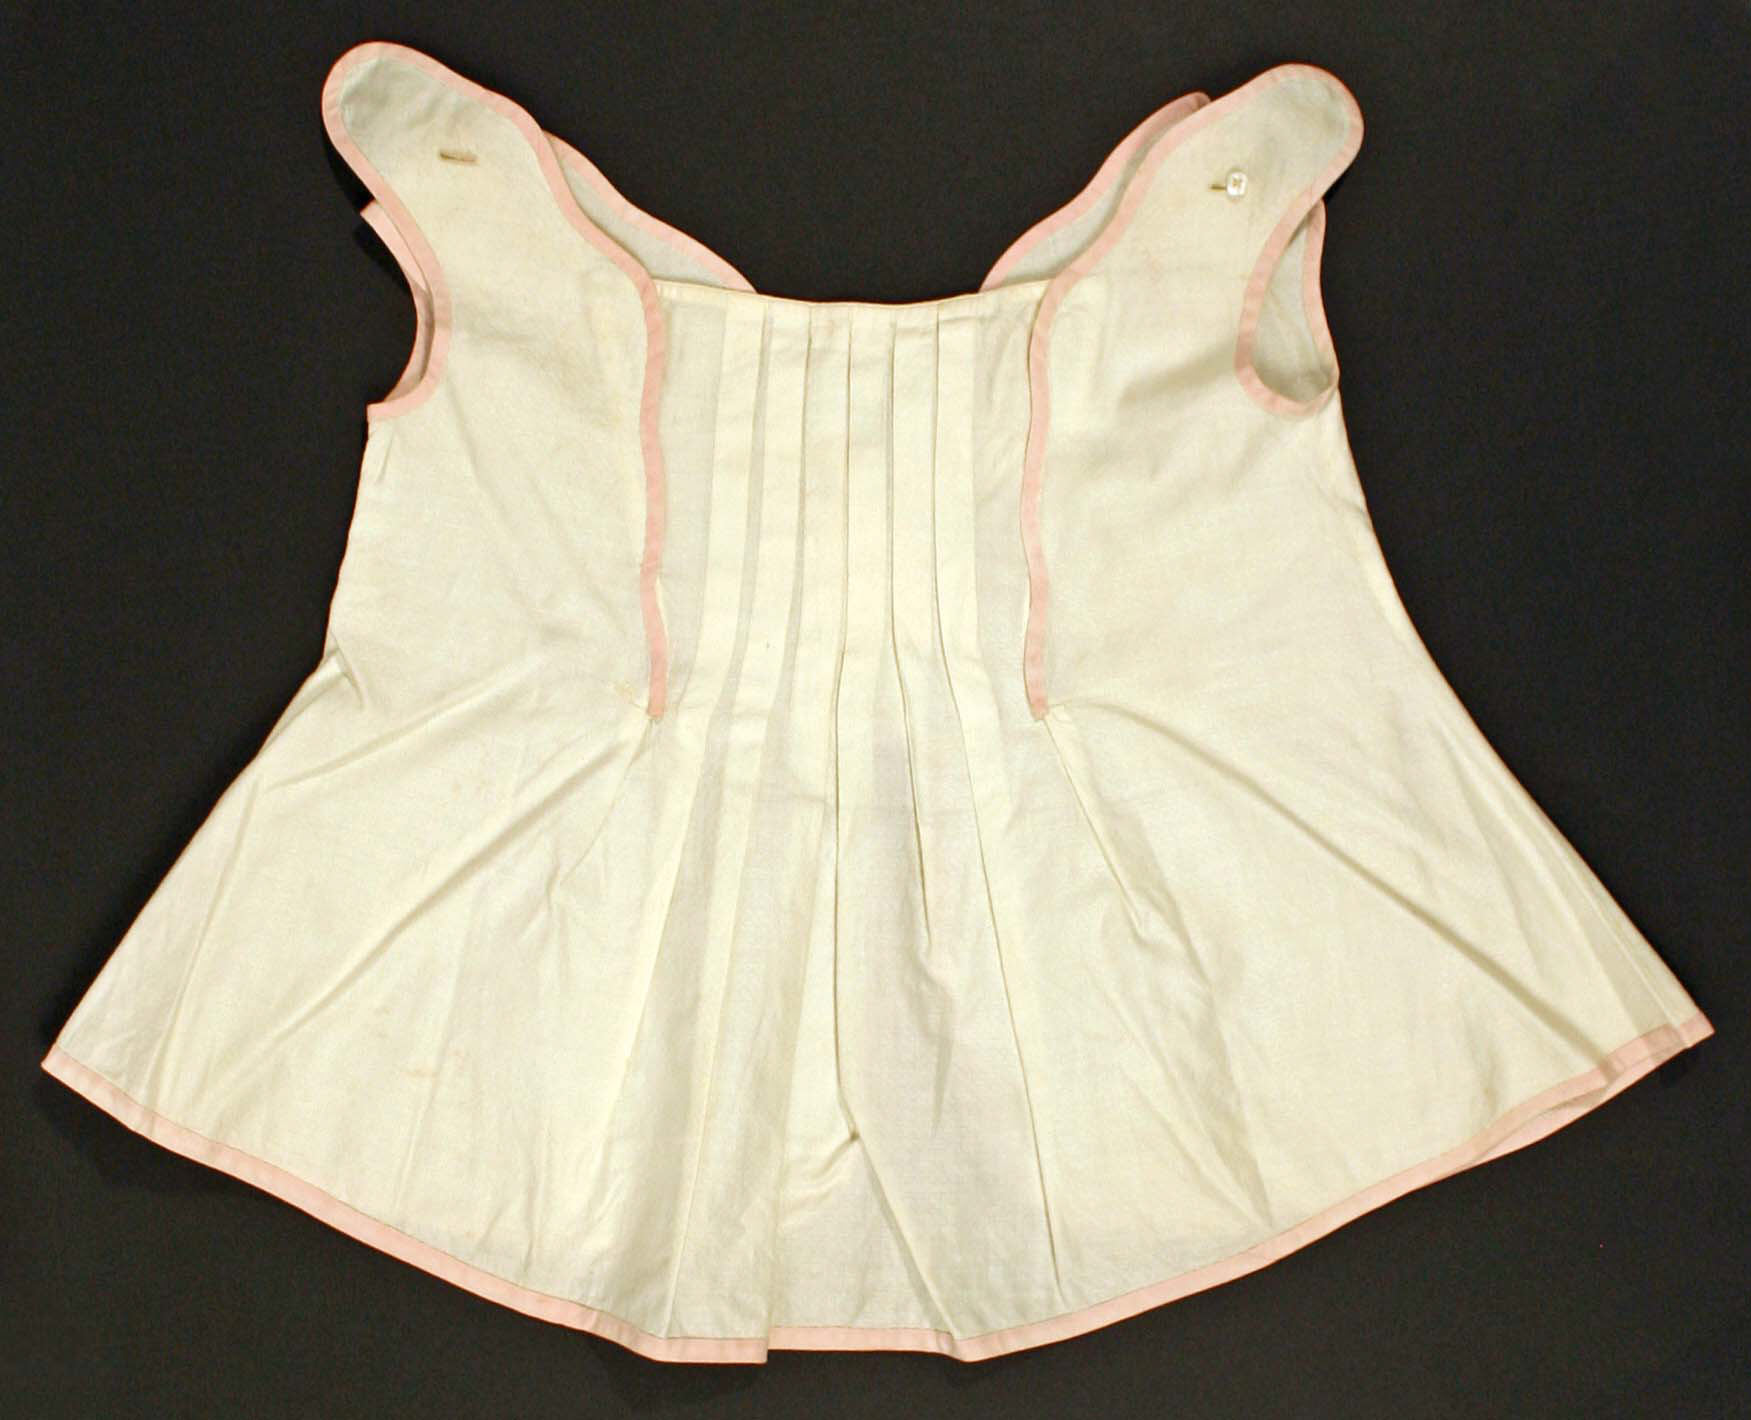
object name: pinafore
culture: american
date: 1860-1869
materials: cotton